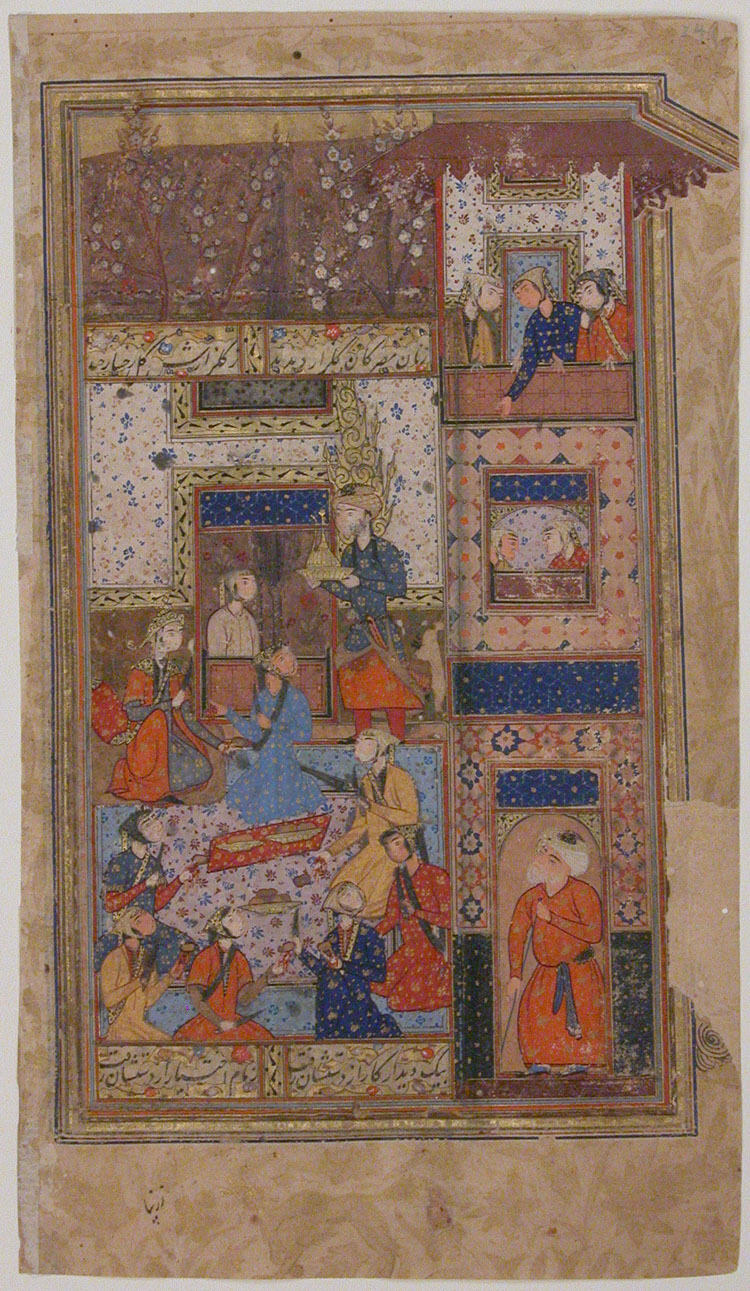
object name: folio from an illustrated manuscript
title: "Yusef Serves for Zulaikha at a Feast", Folio from a Yusuf and Zulaikha of Jami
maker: maulana nur al-din `abd al-rahman jami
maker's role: author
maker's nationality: iranian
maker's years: 1414-1492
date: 1551-1600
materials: gold, paper, watercolor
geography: iran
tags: men,women,dining